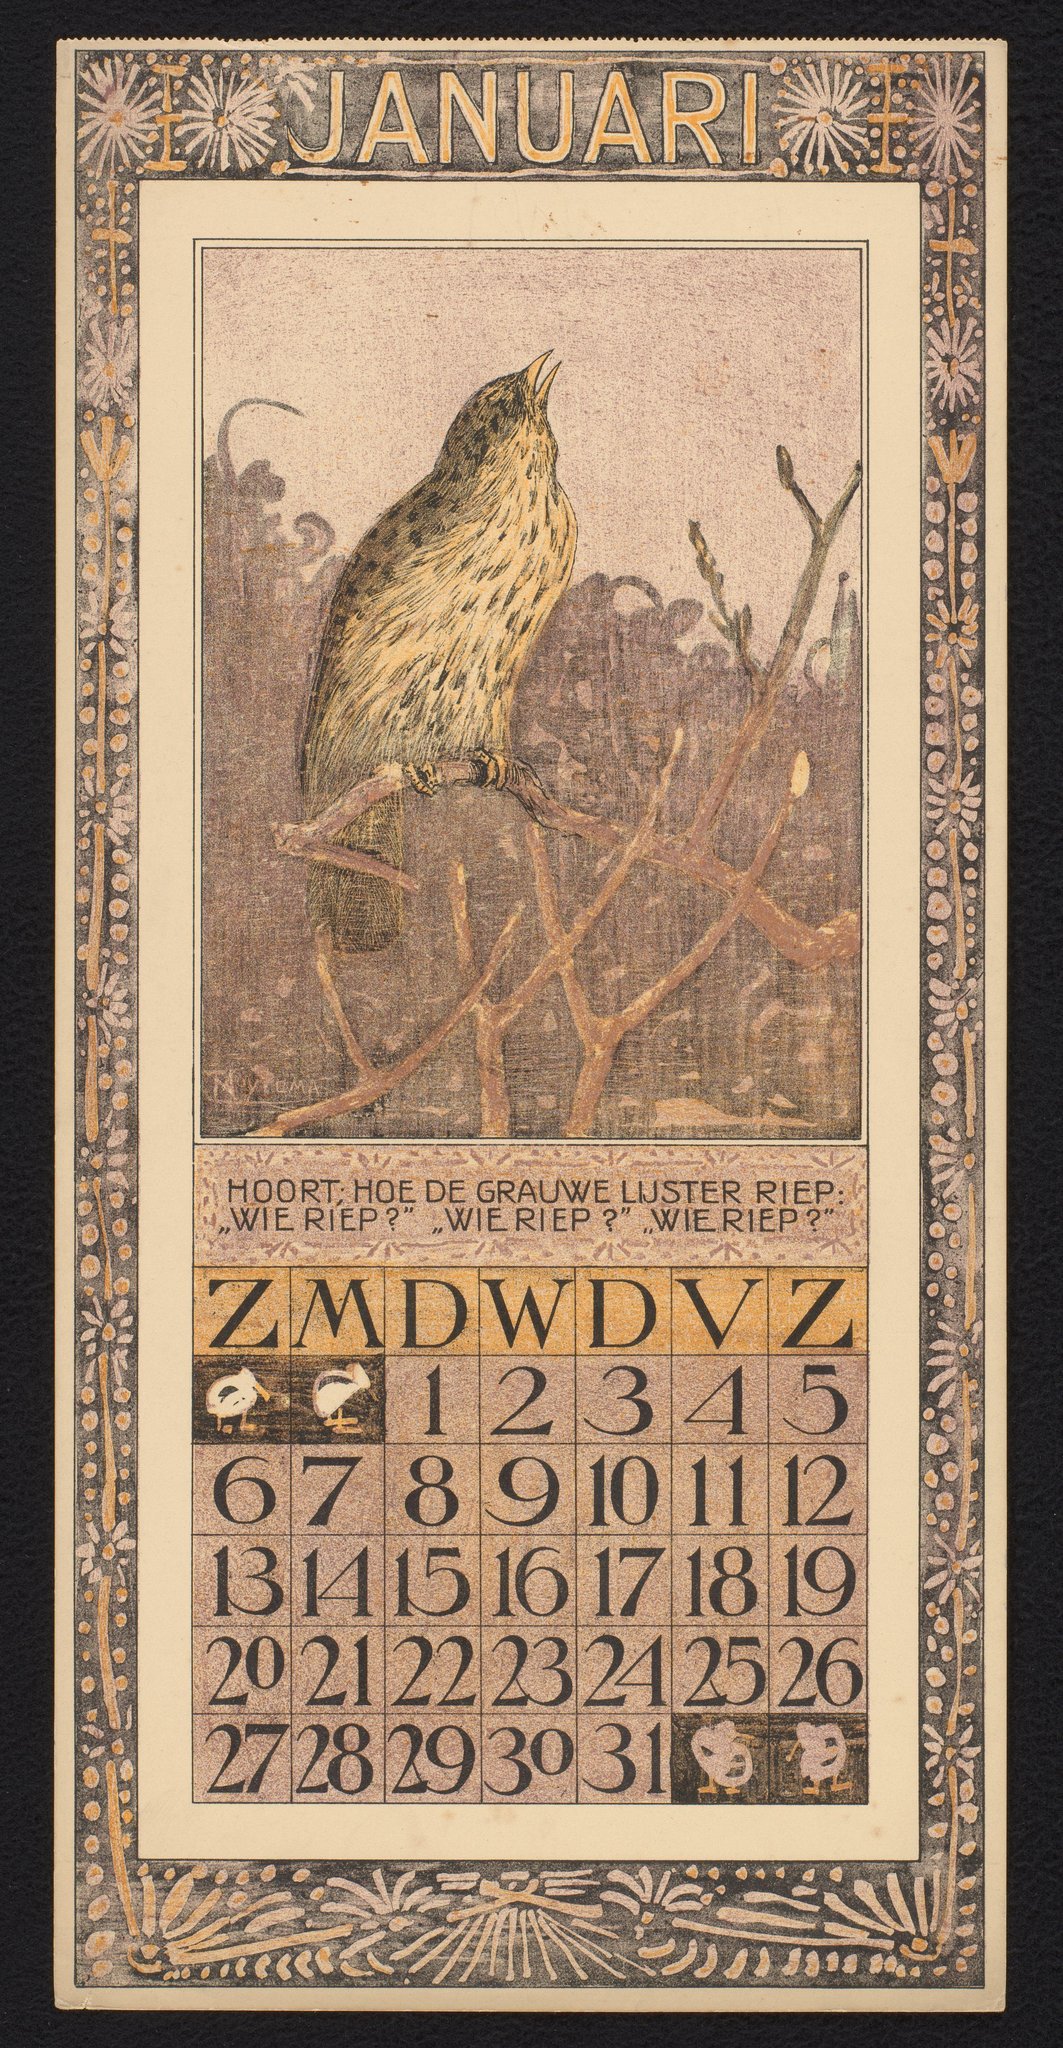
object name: calendar leaf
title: Kalenderblad voor januari 1907 met een zanglijster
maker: theo van hoytema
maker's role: draughtsman, painter, print maker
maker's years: 1863-1917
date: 1906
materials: paper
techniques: lithograph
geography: amsterdam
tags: calendar, almanac, song-birds: thrush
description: Zingende zanglijster op een tak, met het onderschrift: 'Hoort hoe de grauwe lijster riep: 'Wie riep?' 'Wie riep?' 'Wie riep?''.